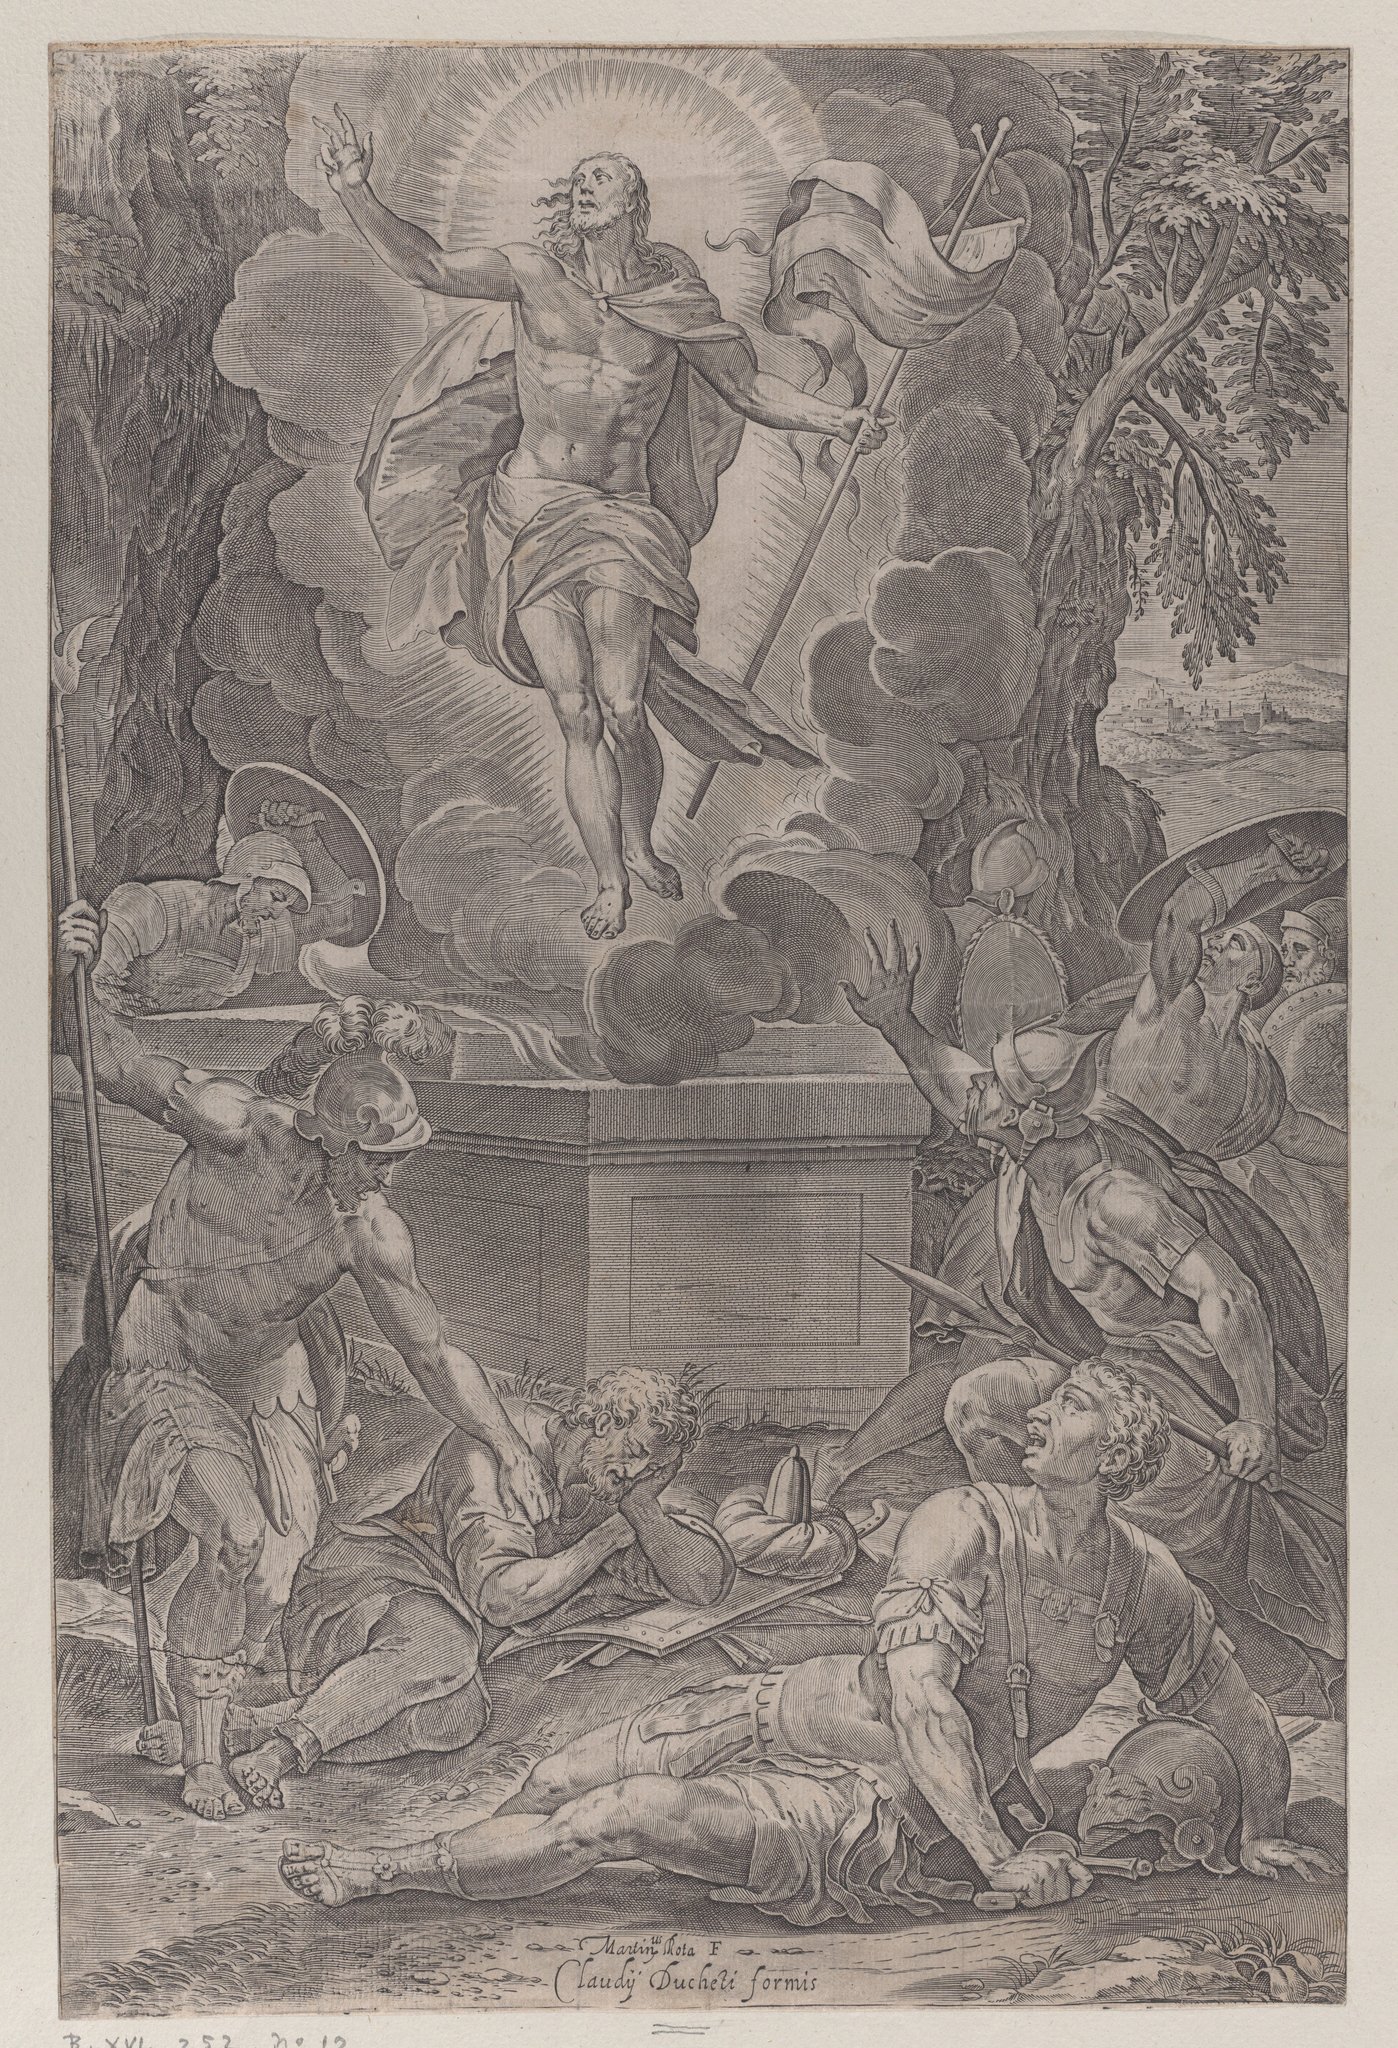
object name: print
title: The Resurrection of Christ, with soldiers awakening before the tomb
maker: martino rota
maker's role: artist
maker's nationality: italian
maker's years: 1520-1583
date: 1565-1583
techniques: engraving